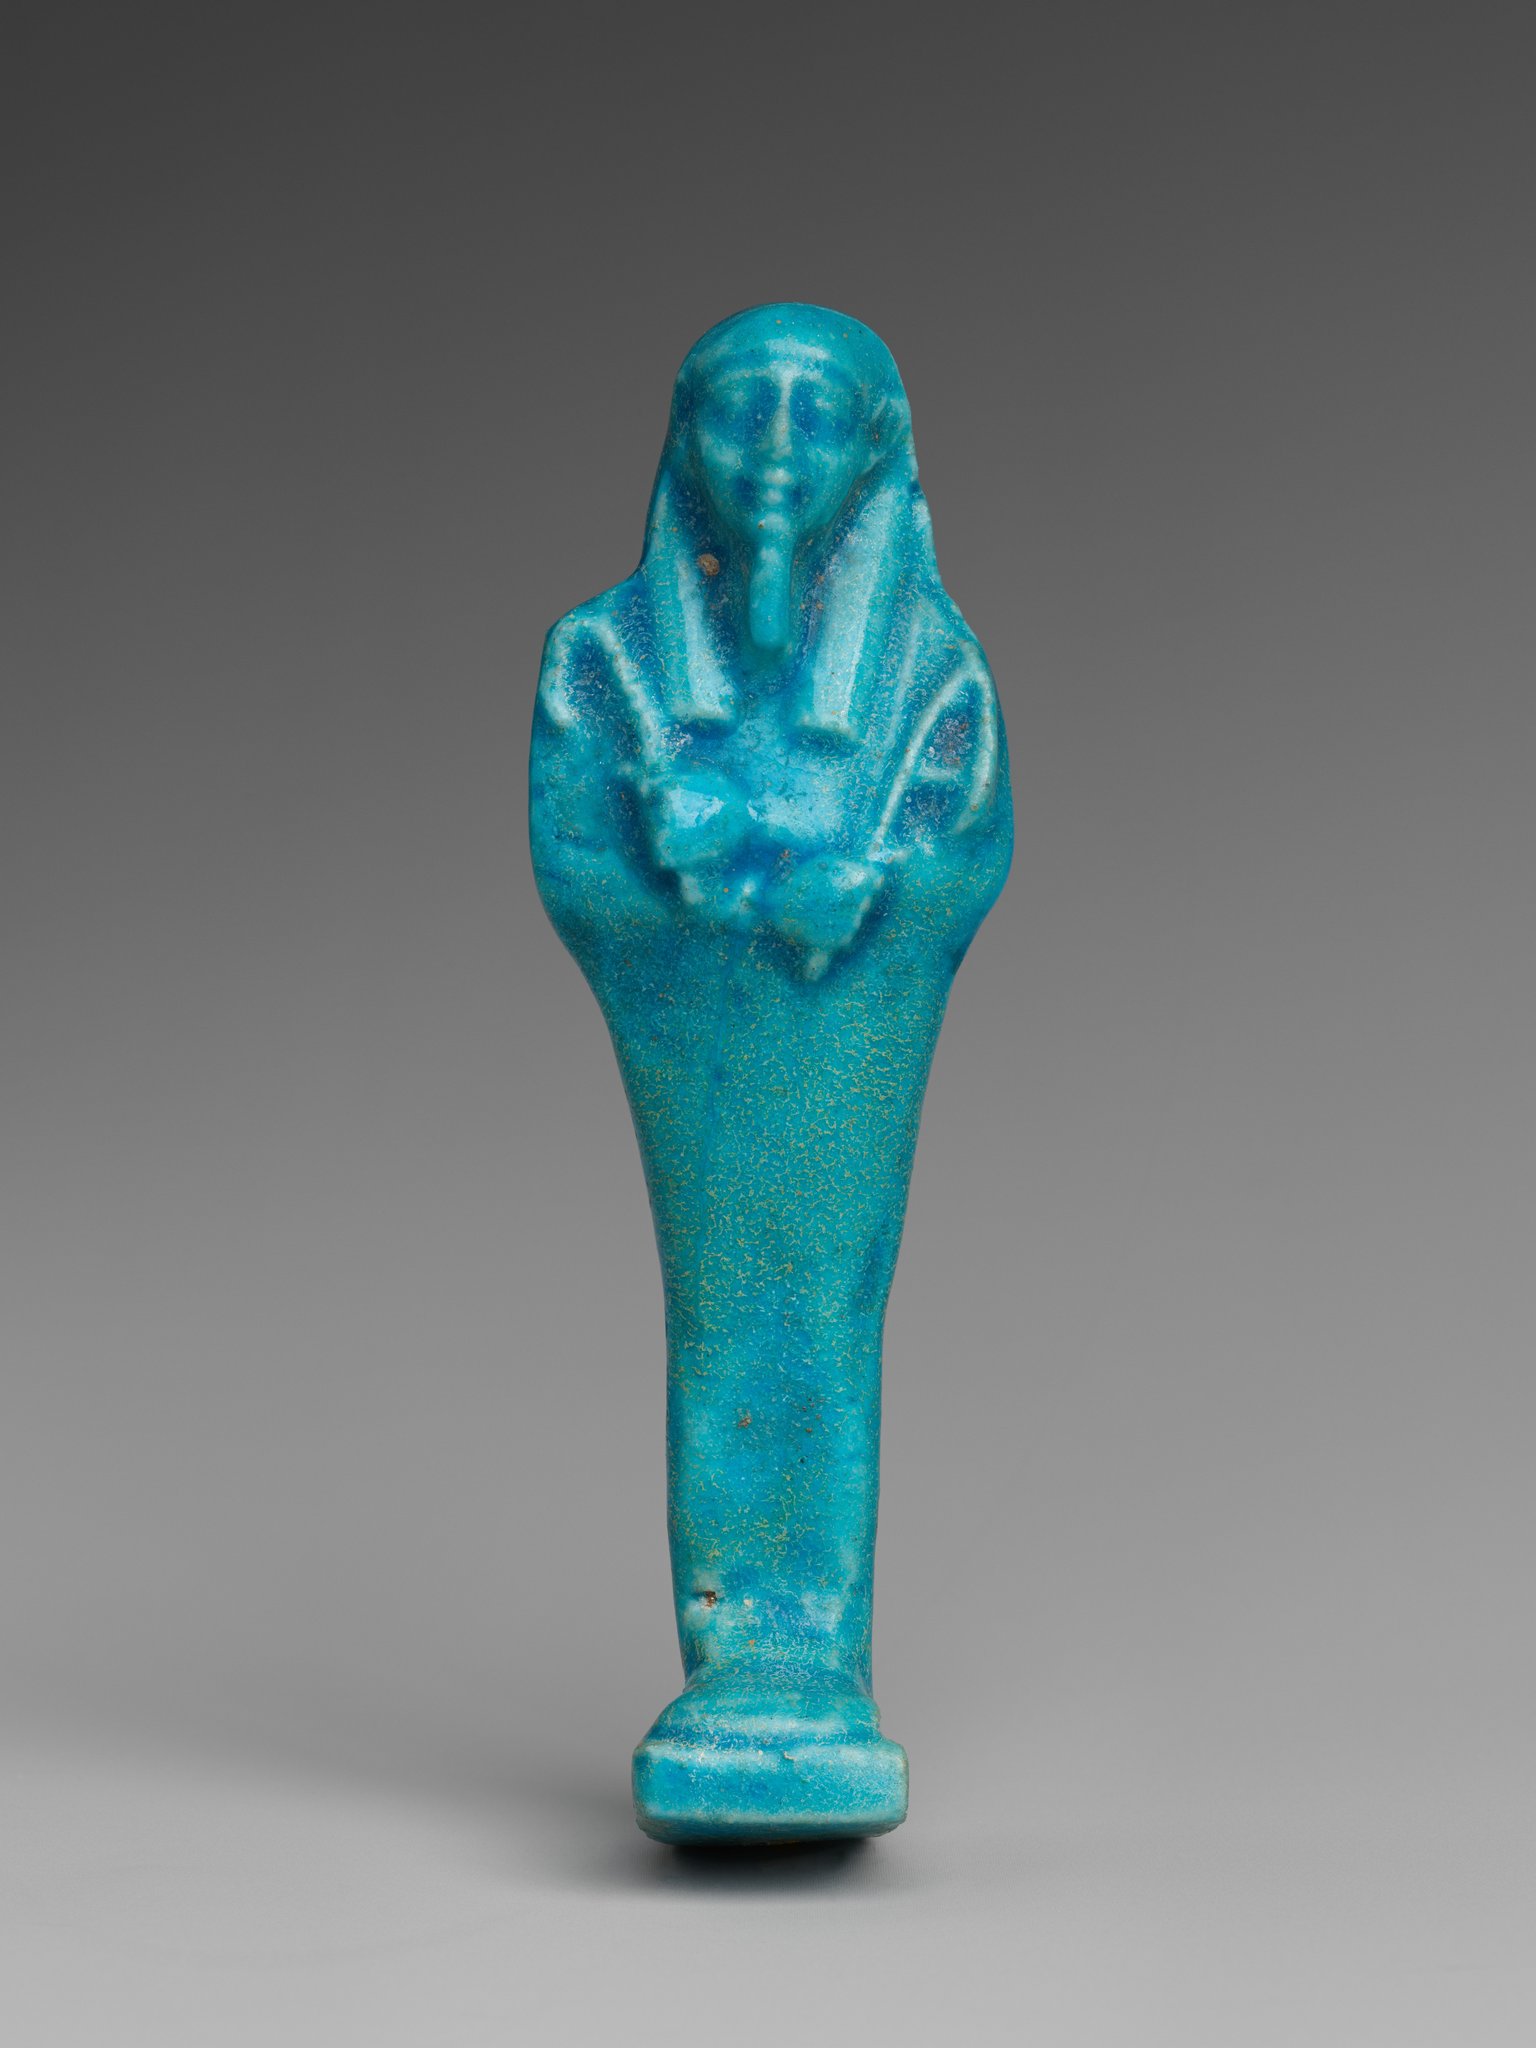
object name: shabti, petosiris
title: Shabti of Petosiris, son of Djedhor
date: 360-300 BCE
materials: faience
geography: egypt